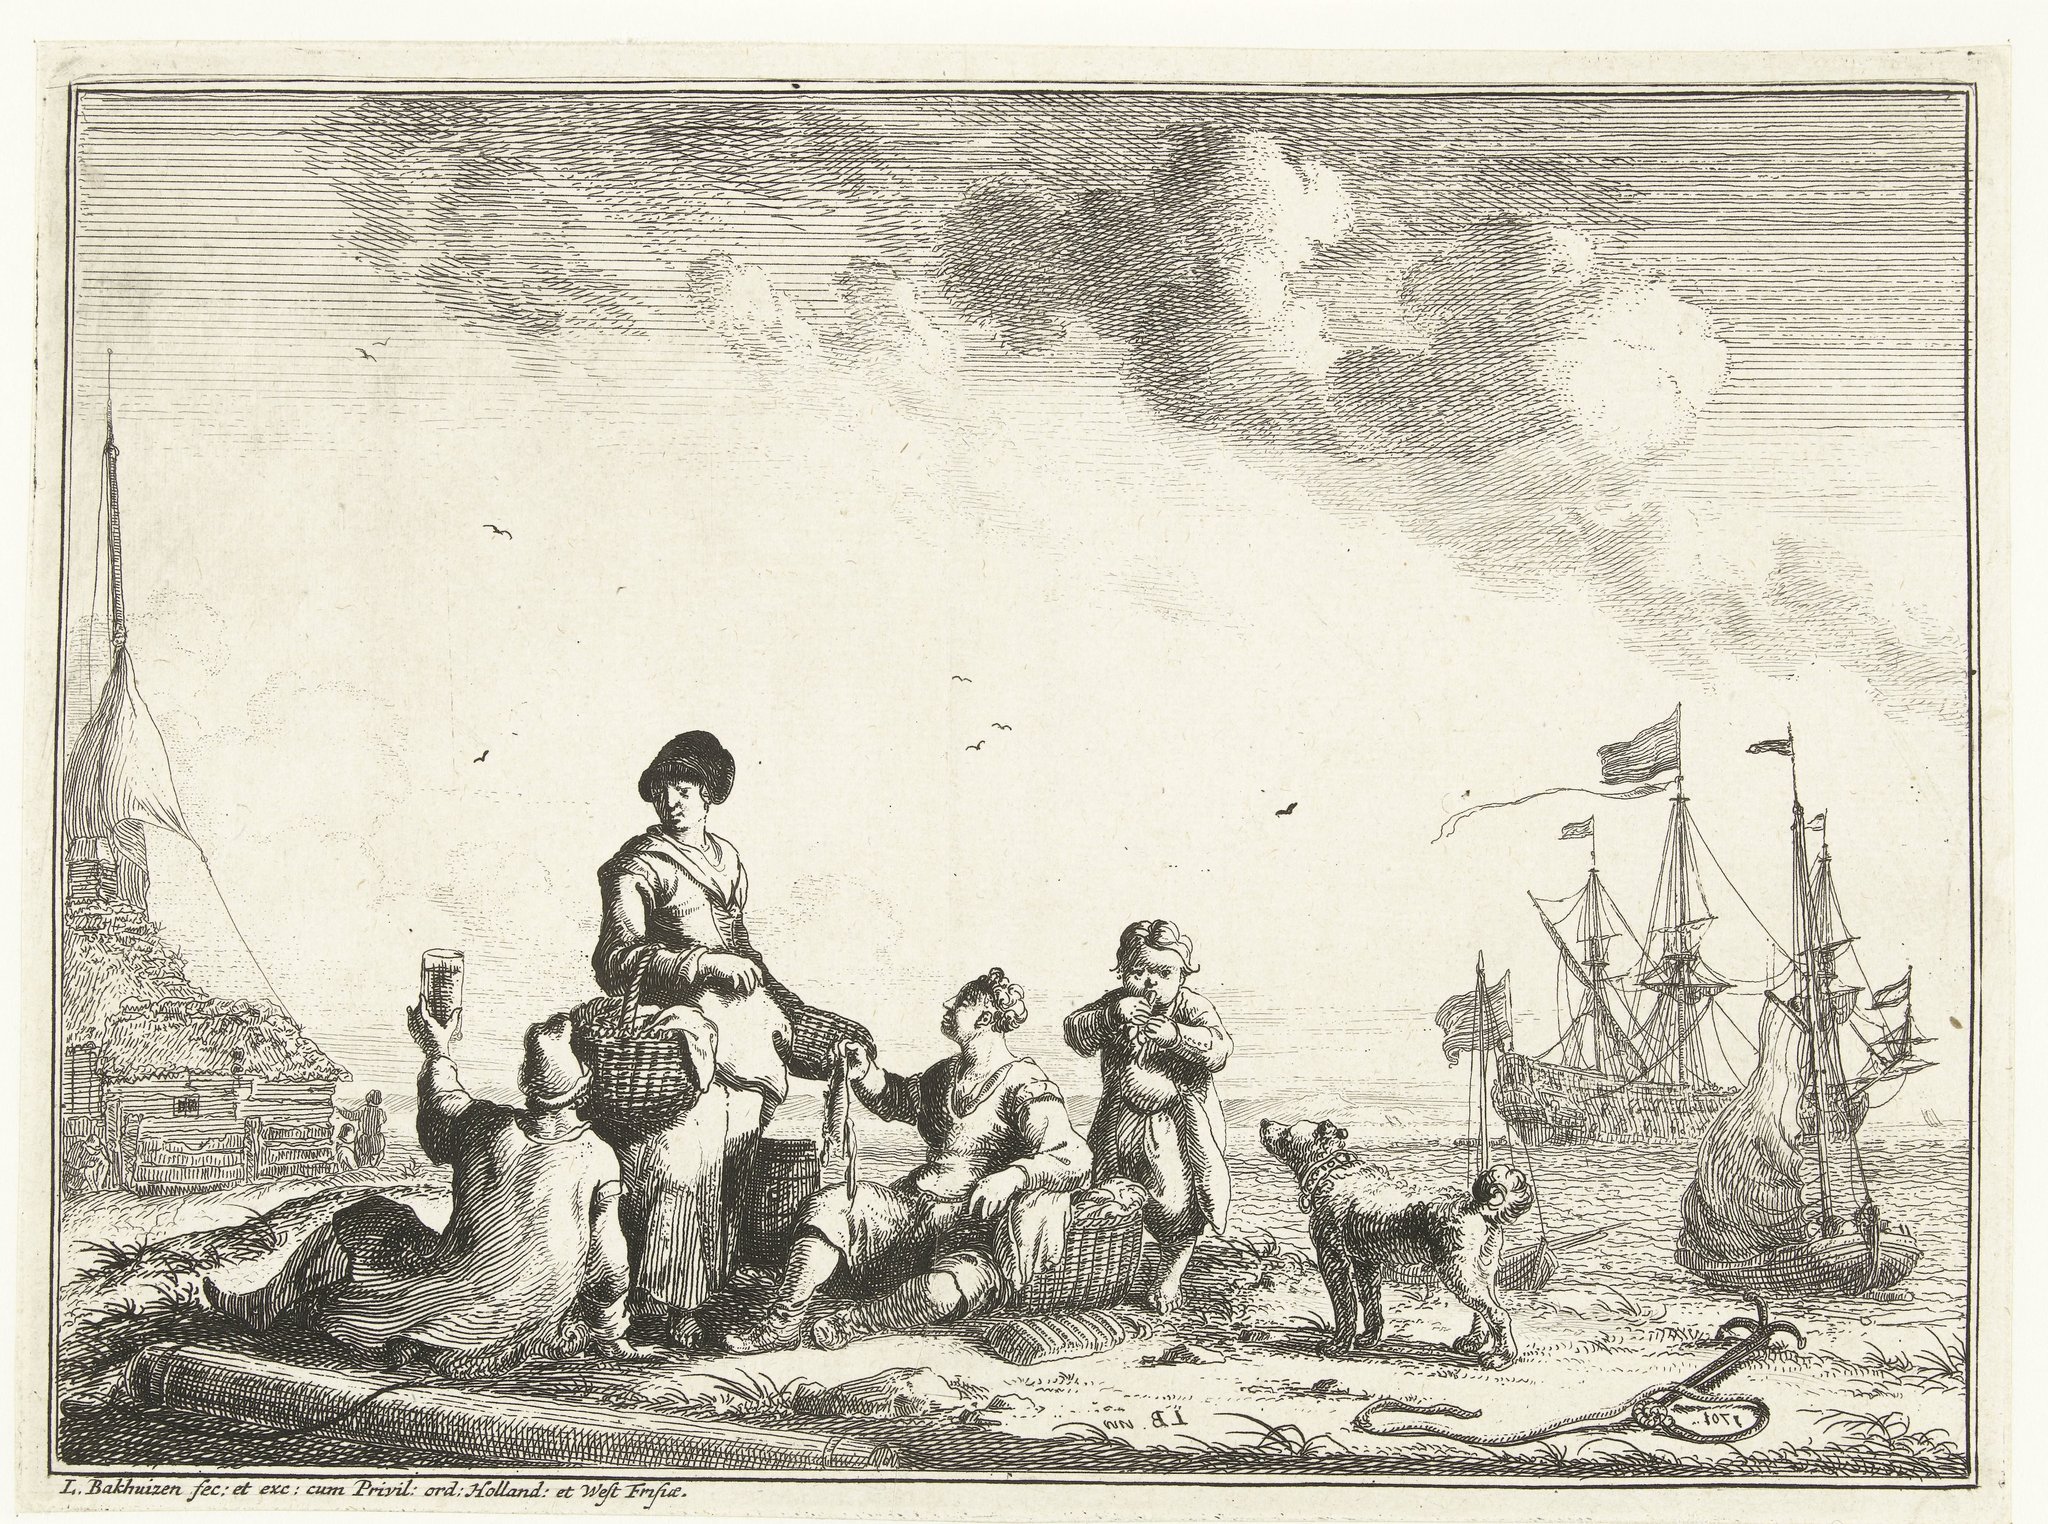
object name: print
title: Zeegezichten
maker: ludolf bakhuysen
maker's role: draughtsman, print maker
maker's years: 1631-1708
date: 1701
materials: paper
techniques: etching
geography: amsterdam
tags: sea (seascape), picnic, alfresco, 'déjeuner sur l'herbe'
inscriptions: collector's mark: Lugt 2228, collector's mark: ‘F Rechberger 1800’ Lugt 2133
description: Een gezelschap bestaande uit een vrouw, twee mannen, een kind en een hond picknicken aan zee. Prent uit een serie met tien zeegezichten.